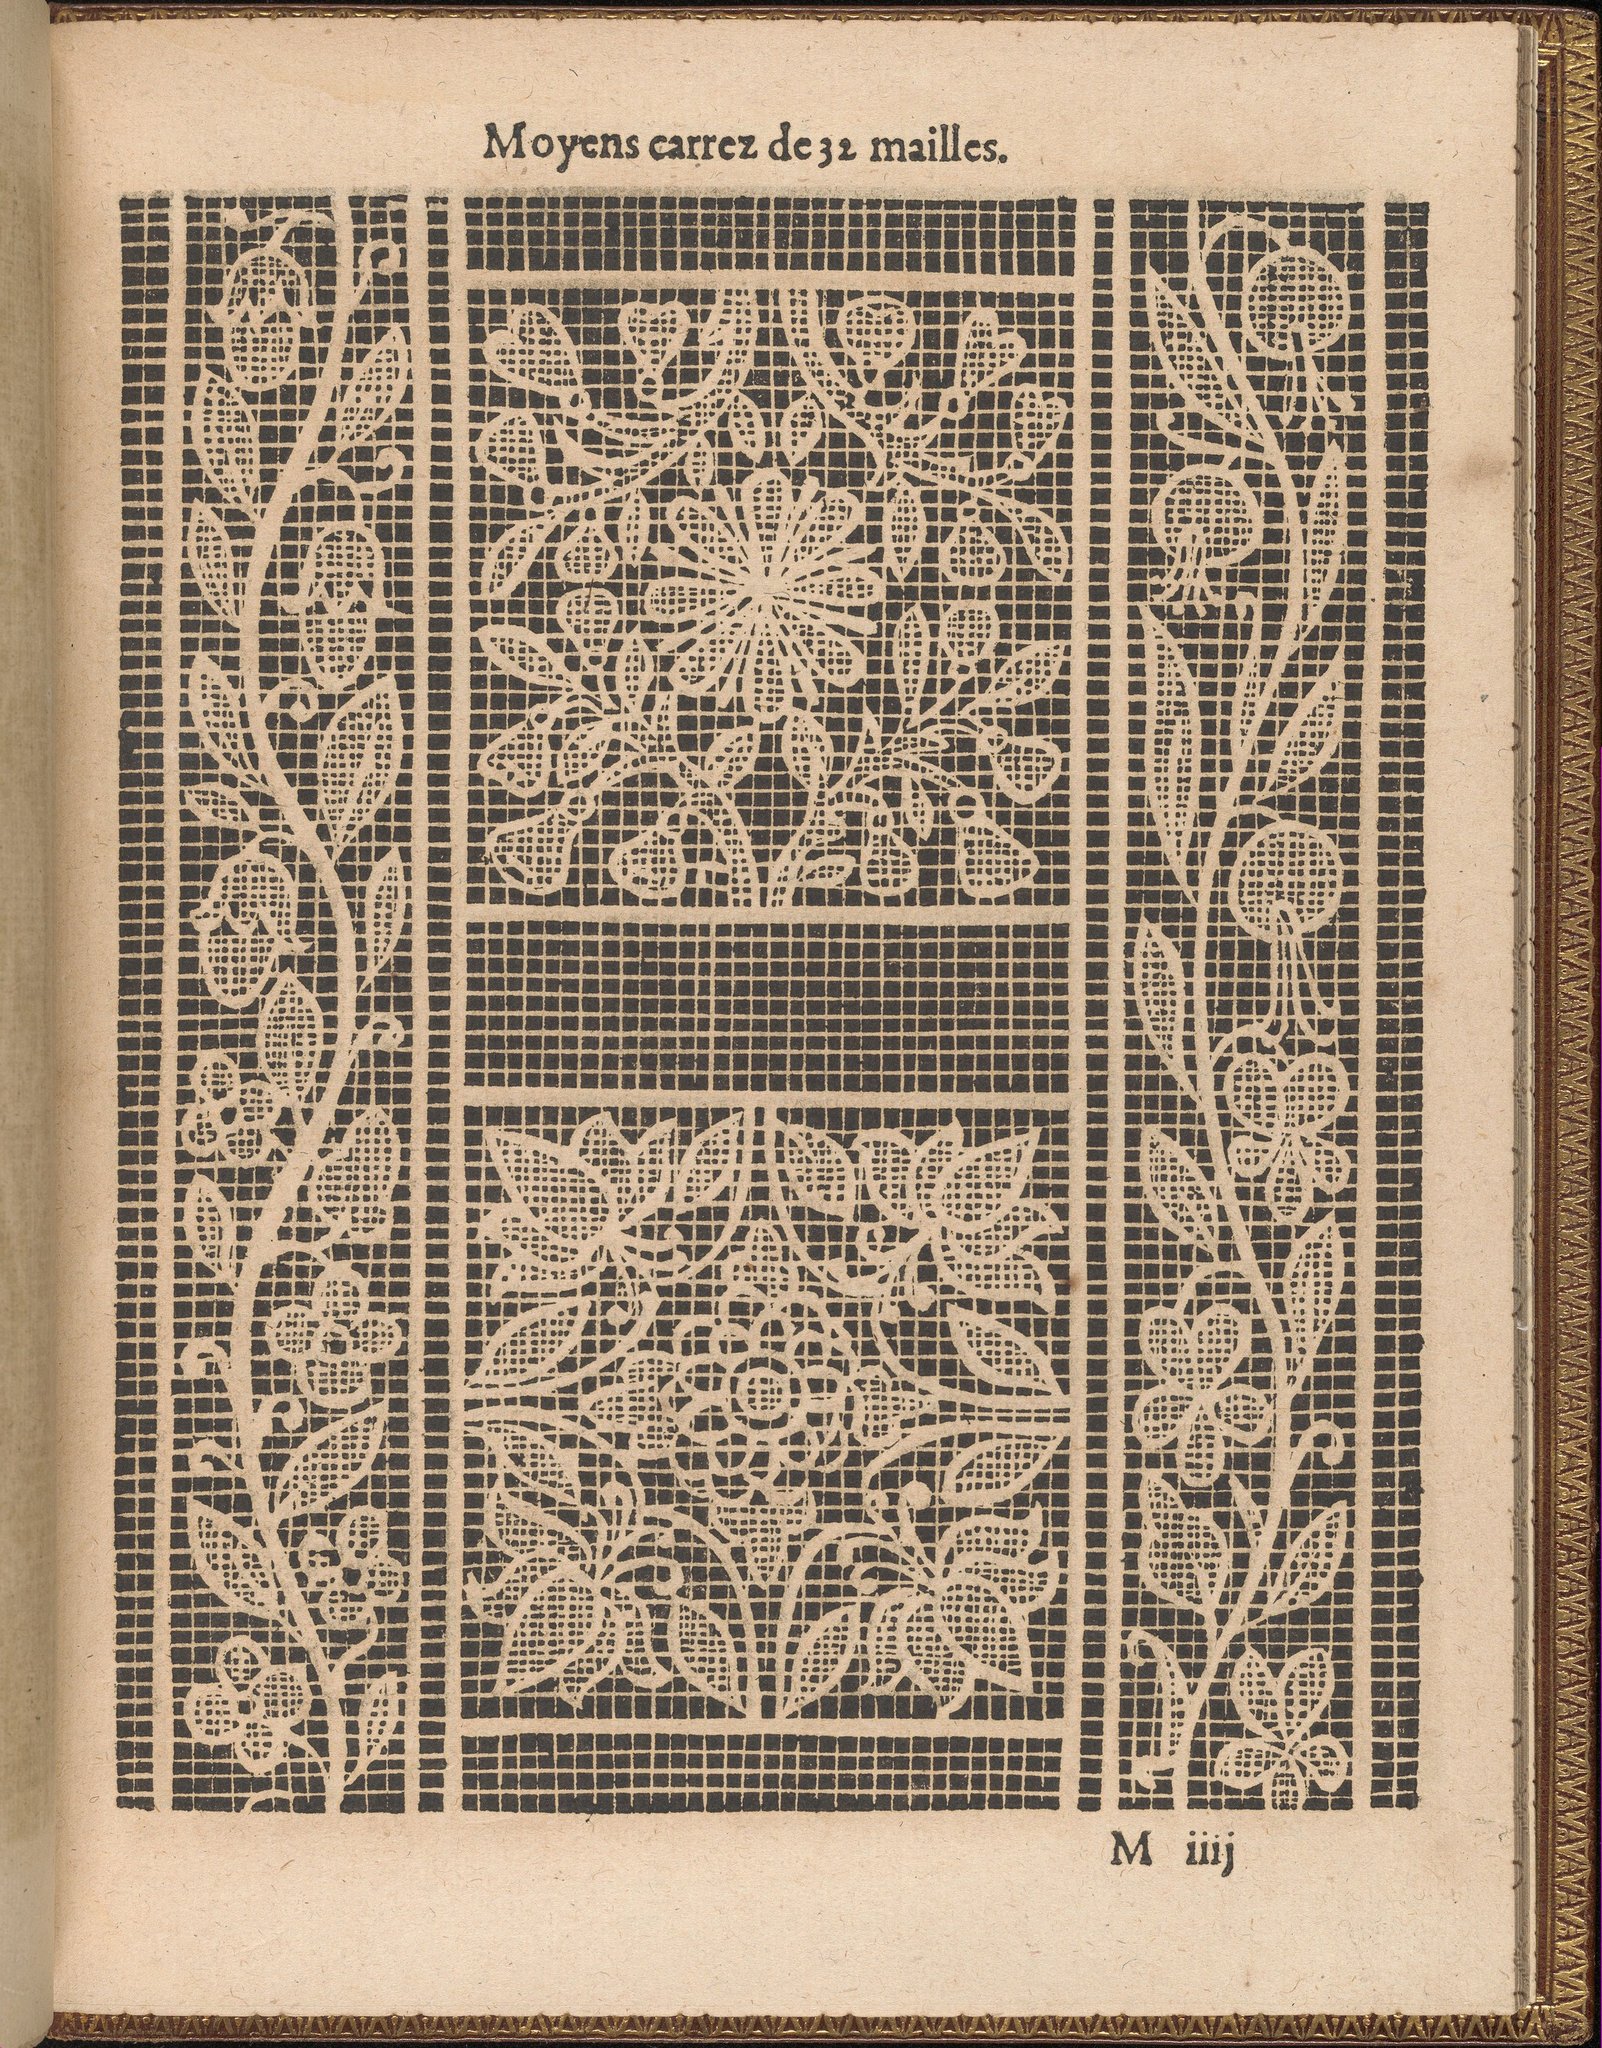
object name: book print ornament architecture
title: La Pratique de l'Aiguille, page 47 (recto)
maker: matthias mignerak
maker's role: author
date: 1605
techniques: woodcut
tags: ornament